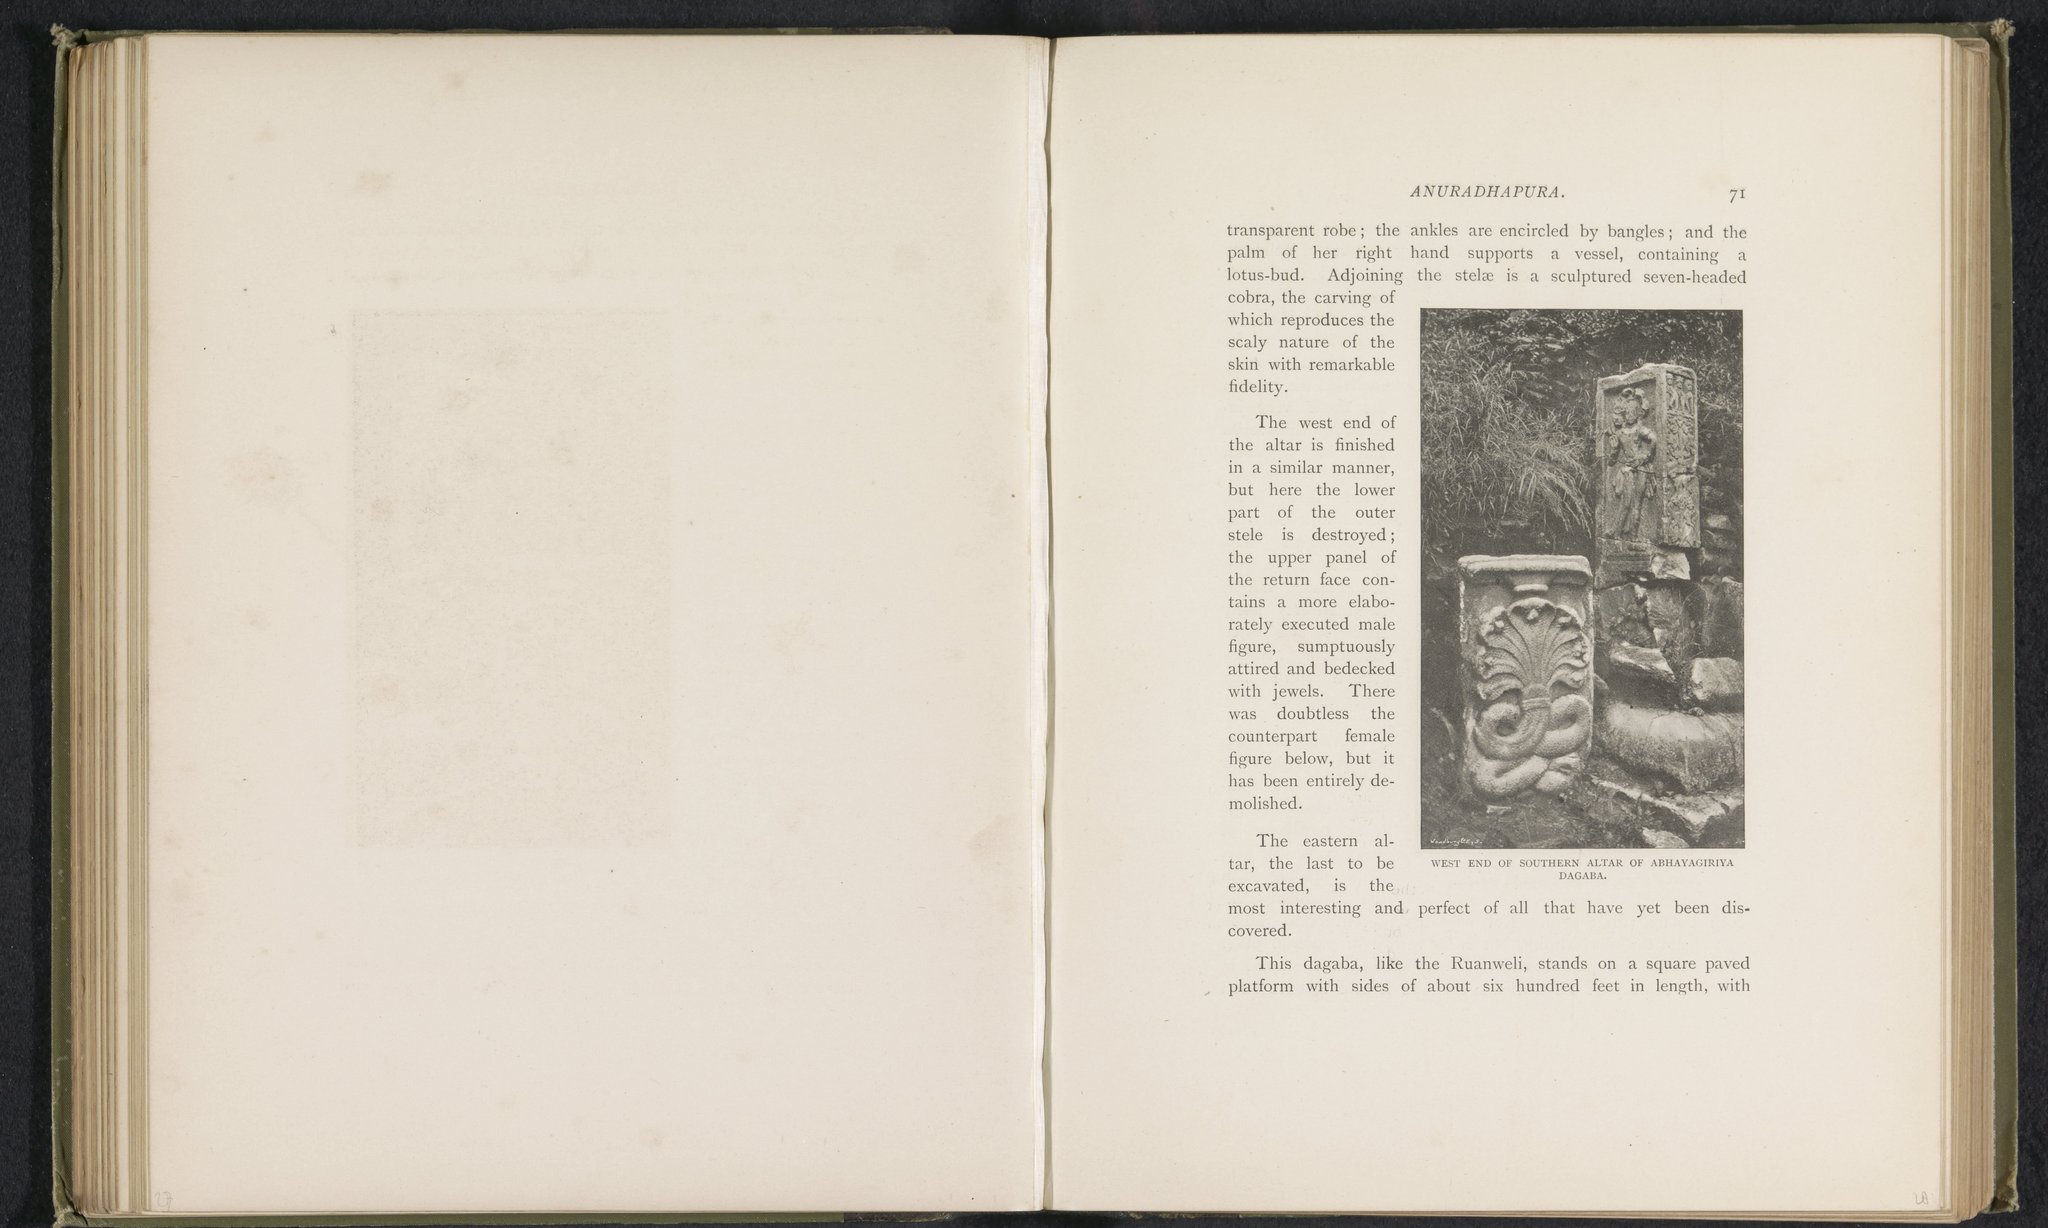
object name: page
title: Part of the southern altar of the Abhayagiri vihāra monastic complex at Anuradhapura, Sri Lanka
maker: henry william cave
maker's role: fotograaf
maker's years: 1854-1913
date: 1896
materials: paper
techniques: autotype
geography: anuradhapura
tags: altar ~ non-christian religions, sculpture (+ relief ~ sculpture)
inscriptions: title: ‘WEST END OF SOUTHERN ALTAR OF ABHAYAGIRIYA DAGABA.’, signature: ‘Woodbury P [?]’